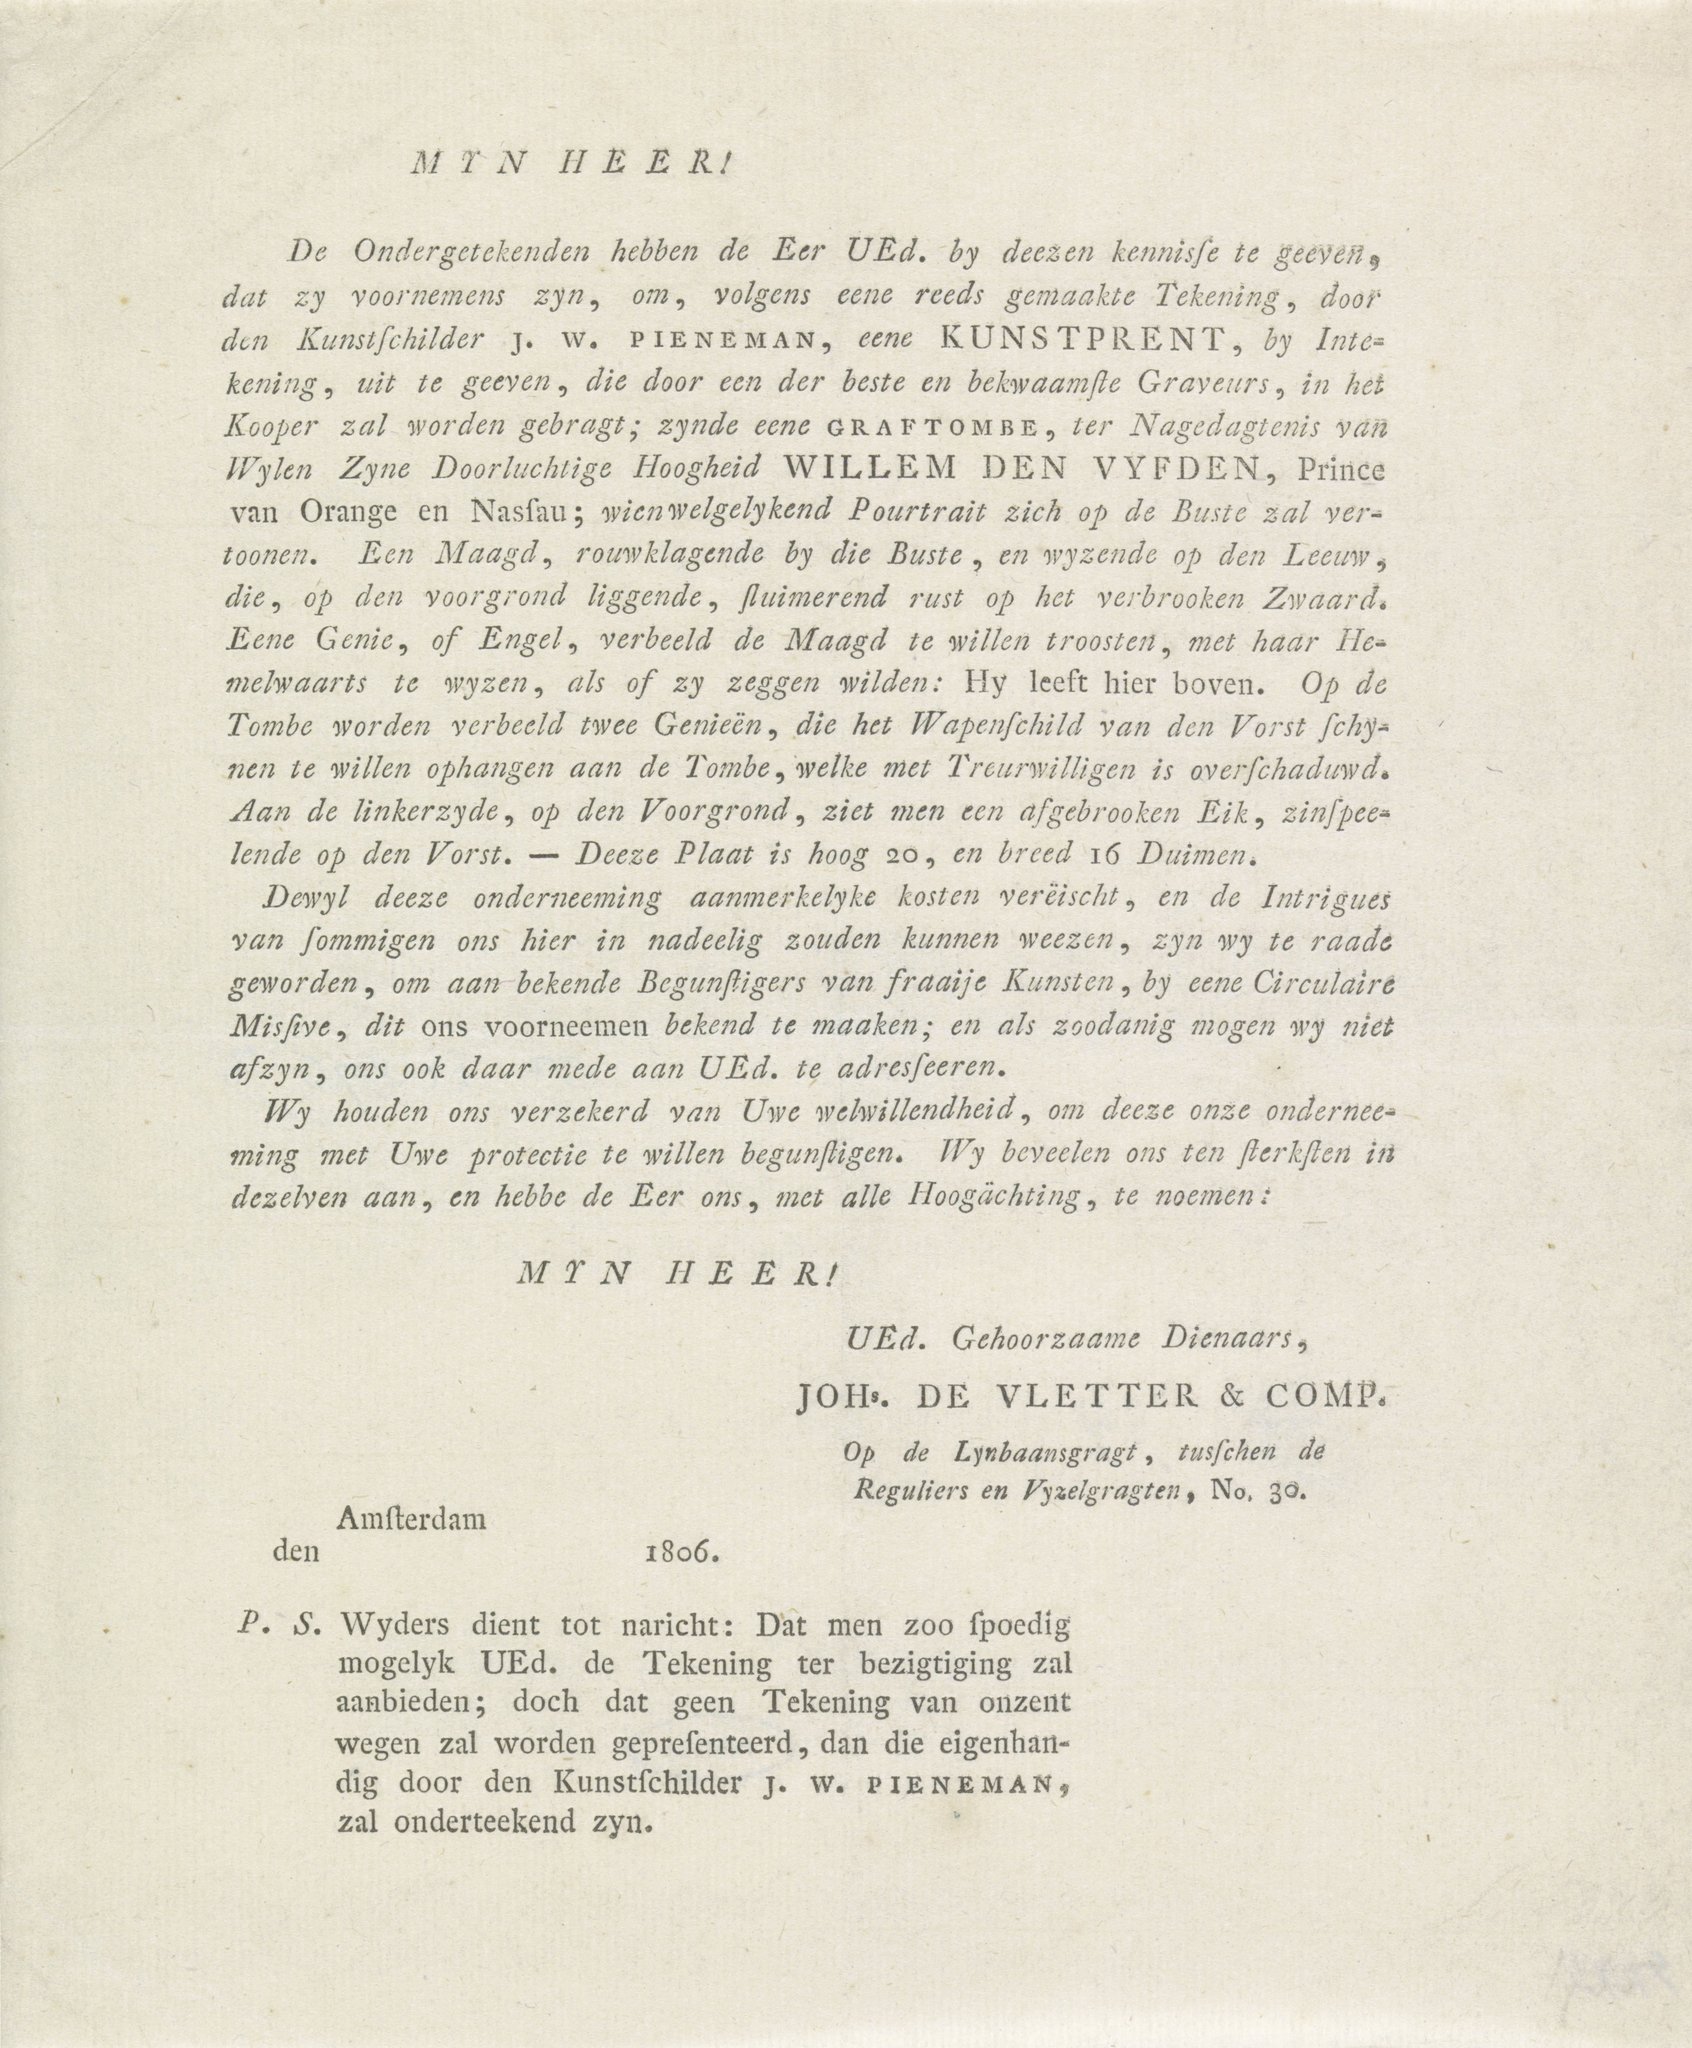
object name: text sheet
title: Aankondiging van een prent ter nagedachtenis aan prins Willem V, 1806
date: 1806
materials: paper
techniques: letterpress printing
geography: amsterdam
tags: the hague, william v (prince of orange)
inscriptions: collector's mark: Lugt 2228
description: Gedrukte aankondiging van de uitgave van een prent ter nagedachtenis aan prins Willem V, overleden op 9 april 1806.